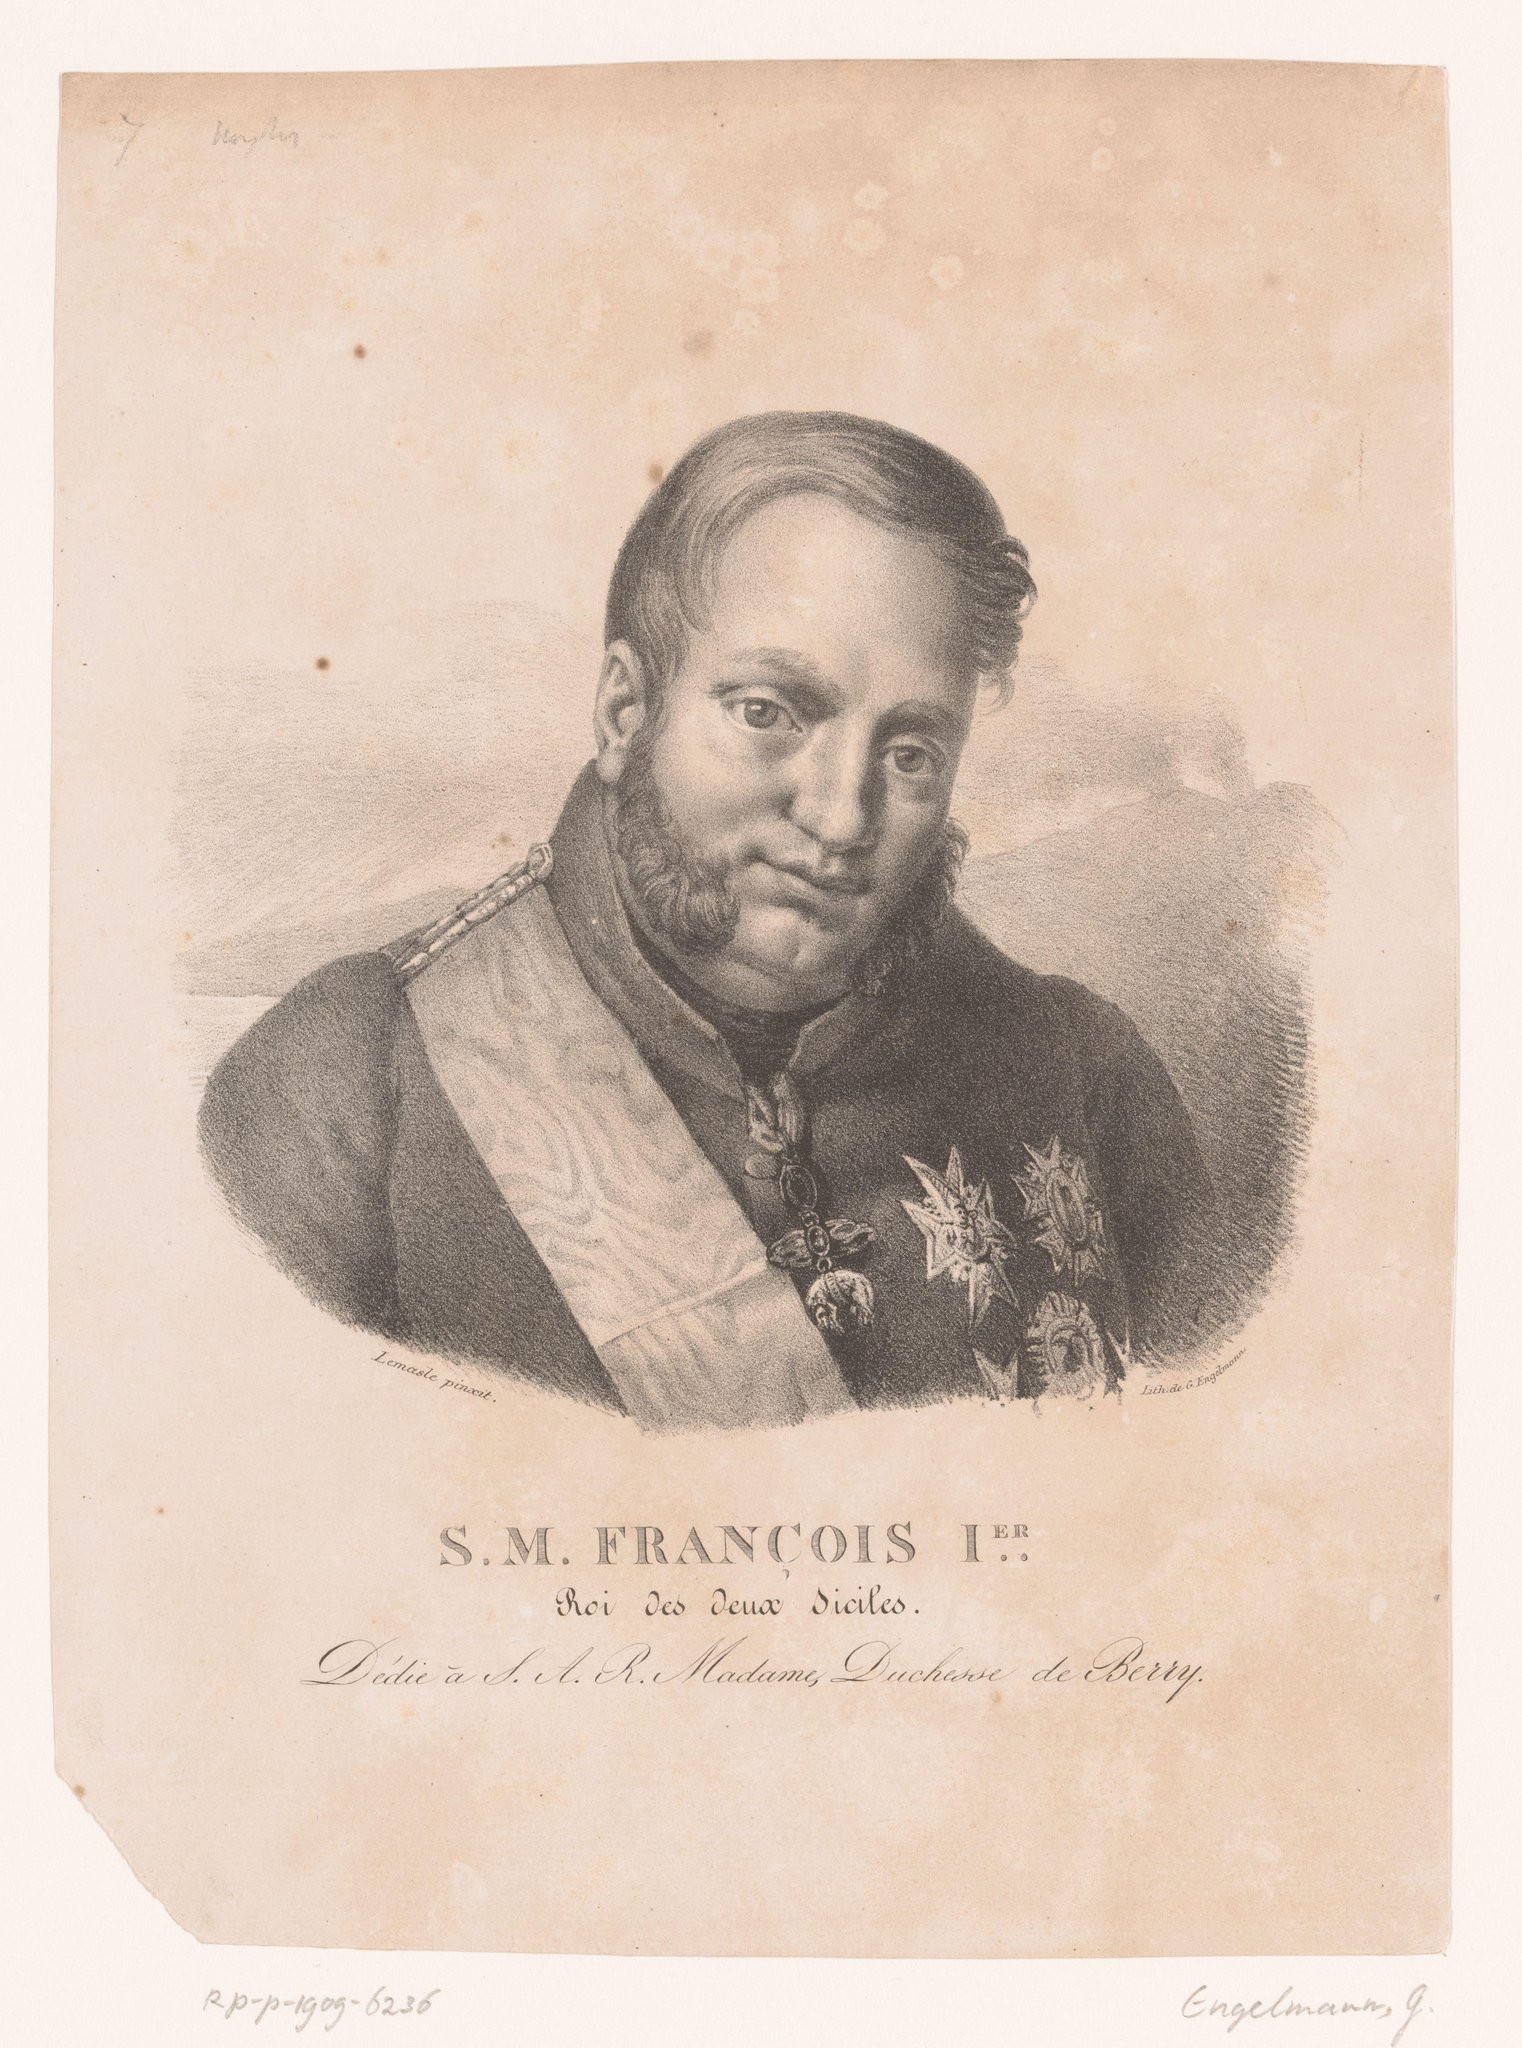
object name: print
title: Portret van Frans I der Beide Siciliën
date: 1816-1839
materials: paper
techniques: lithograph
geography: paris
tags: naples, historical persons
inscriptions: collector's mark: Lugt 2228a